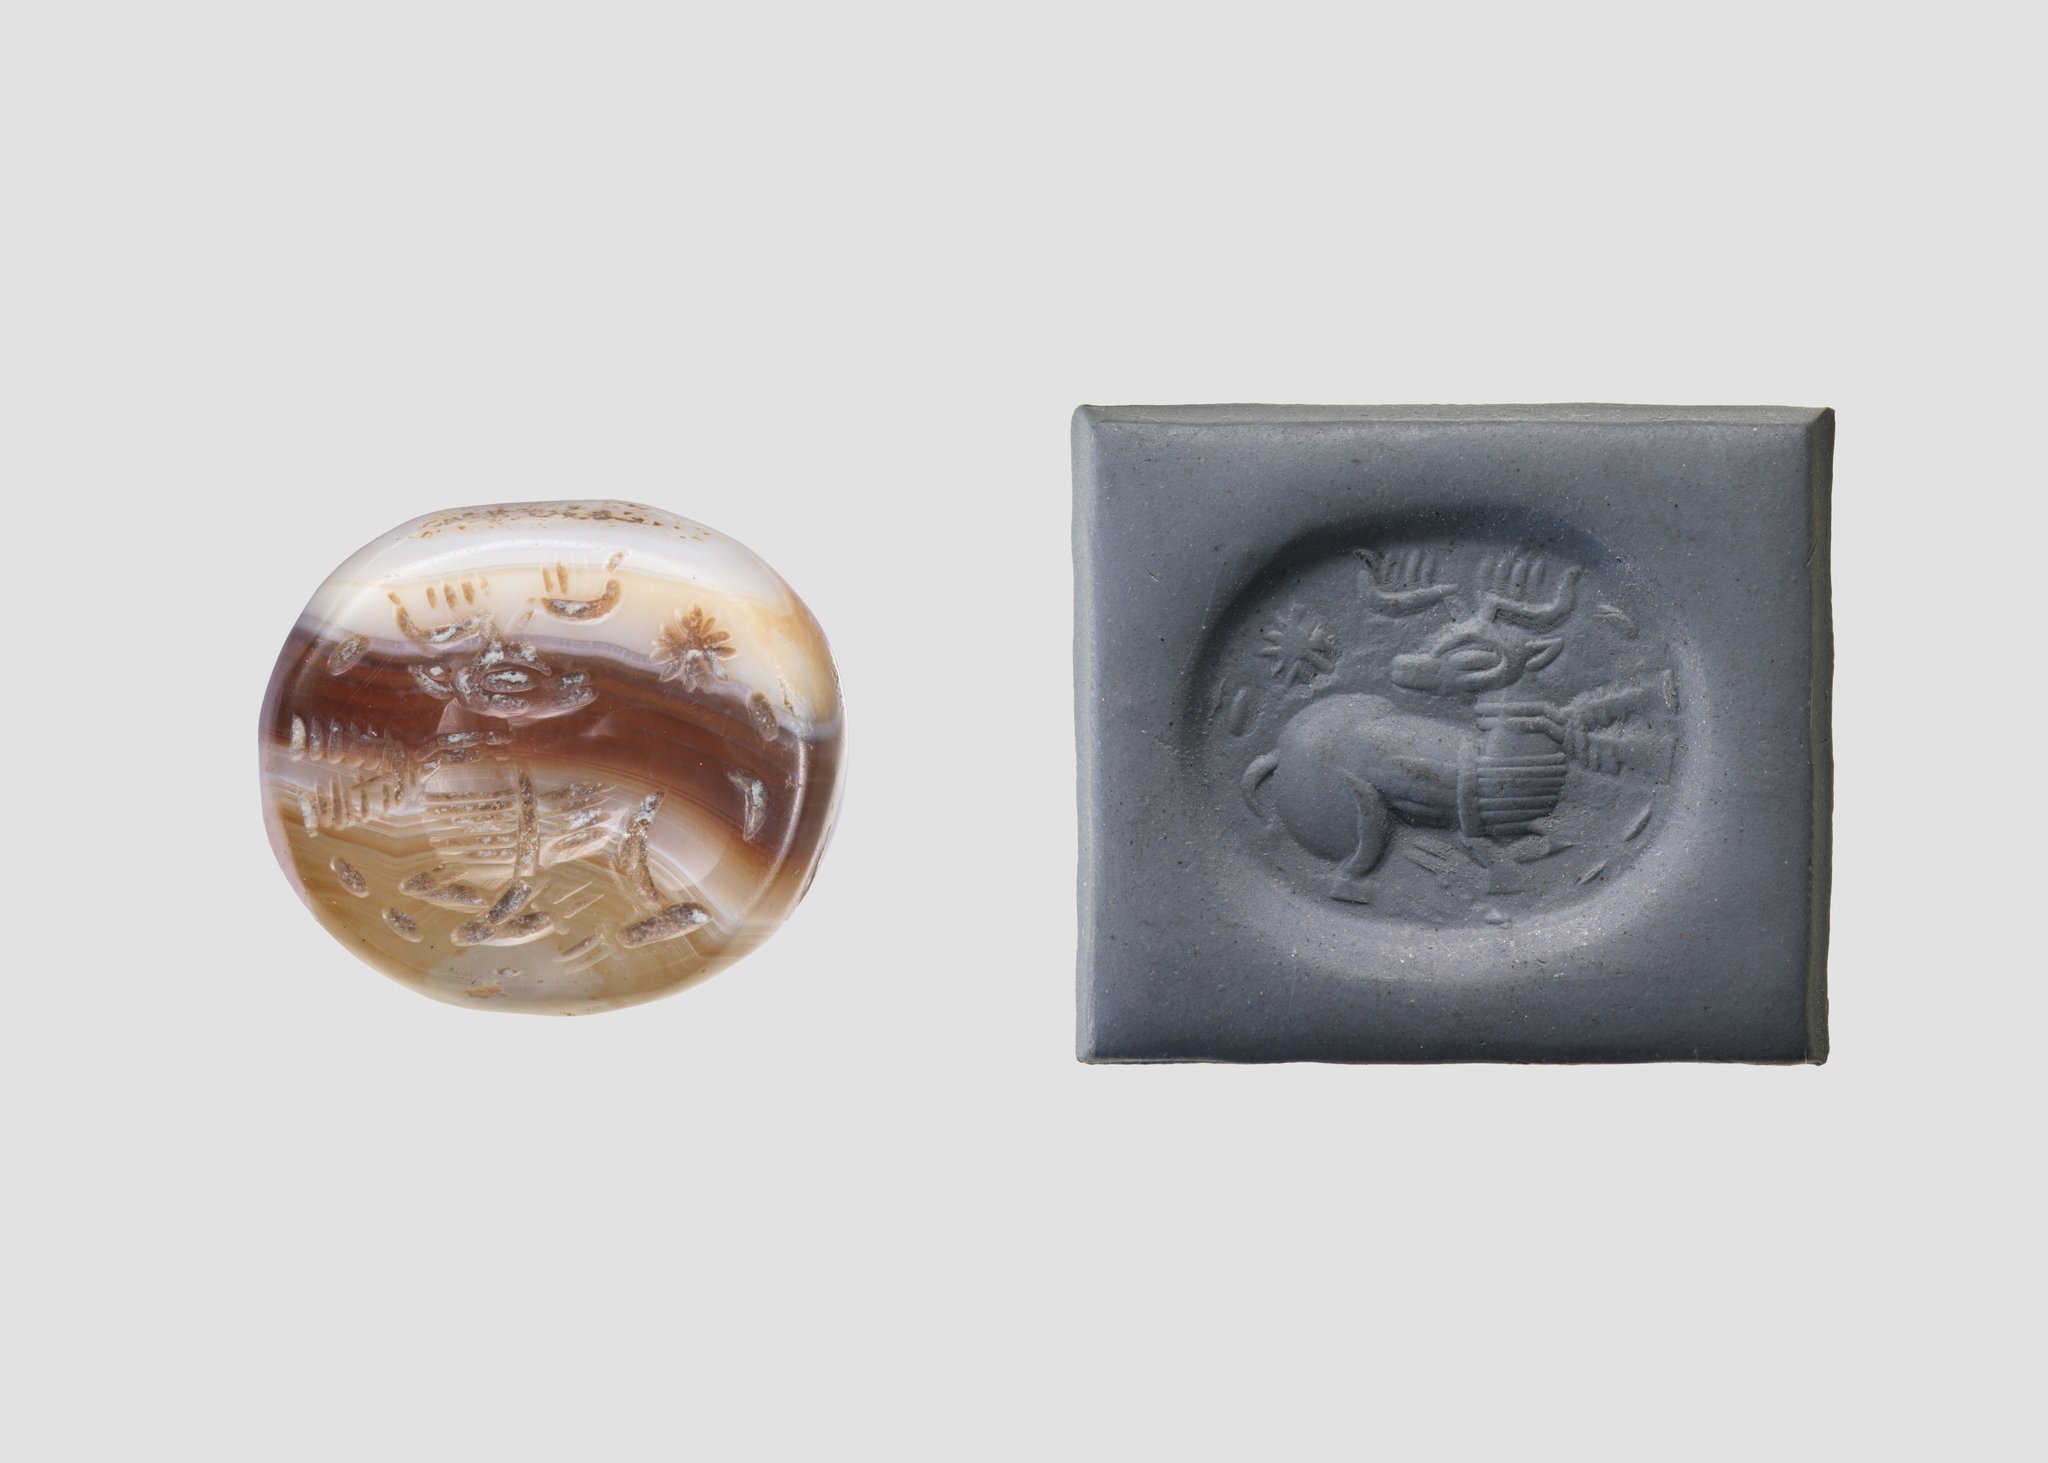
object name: stamp seal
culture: sasanian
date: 201-700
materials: stone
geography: iran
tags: animals